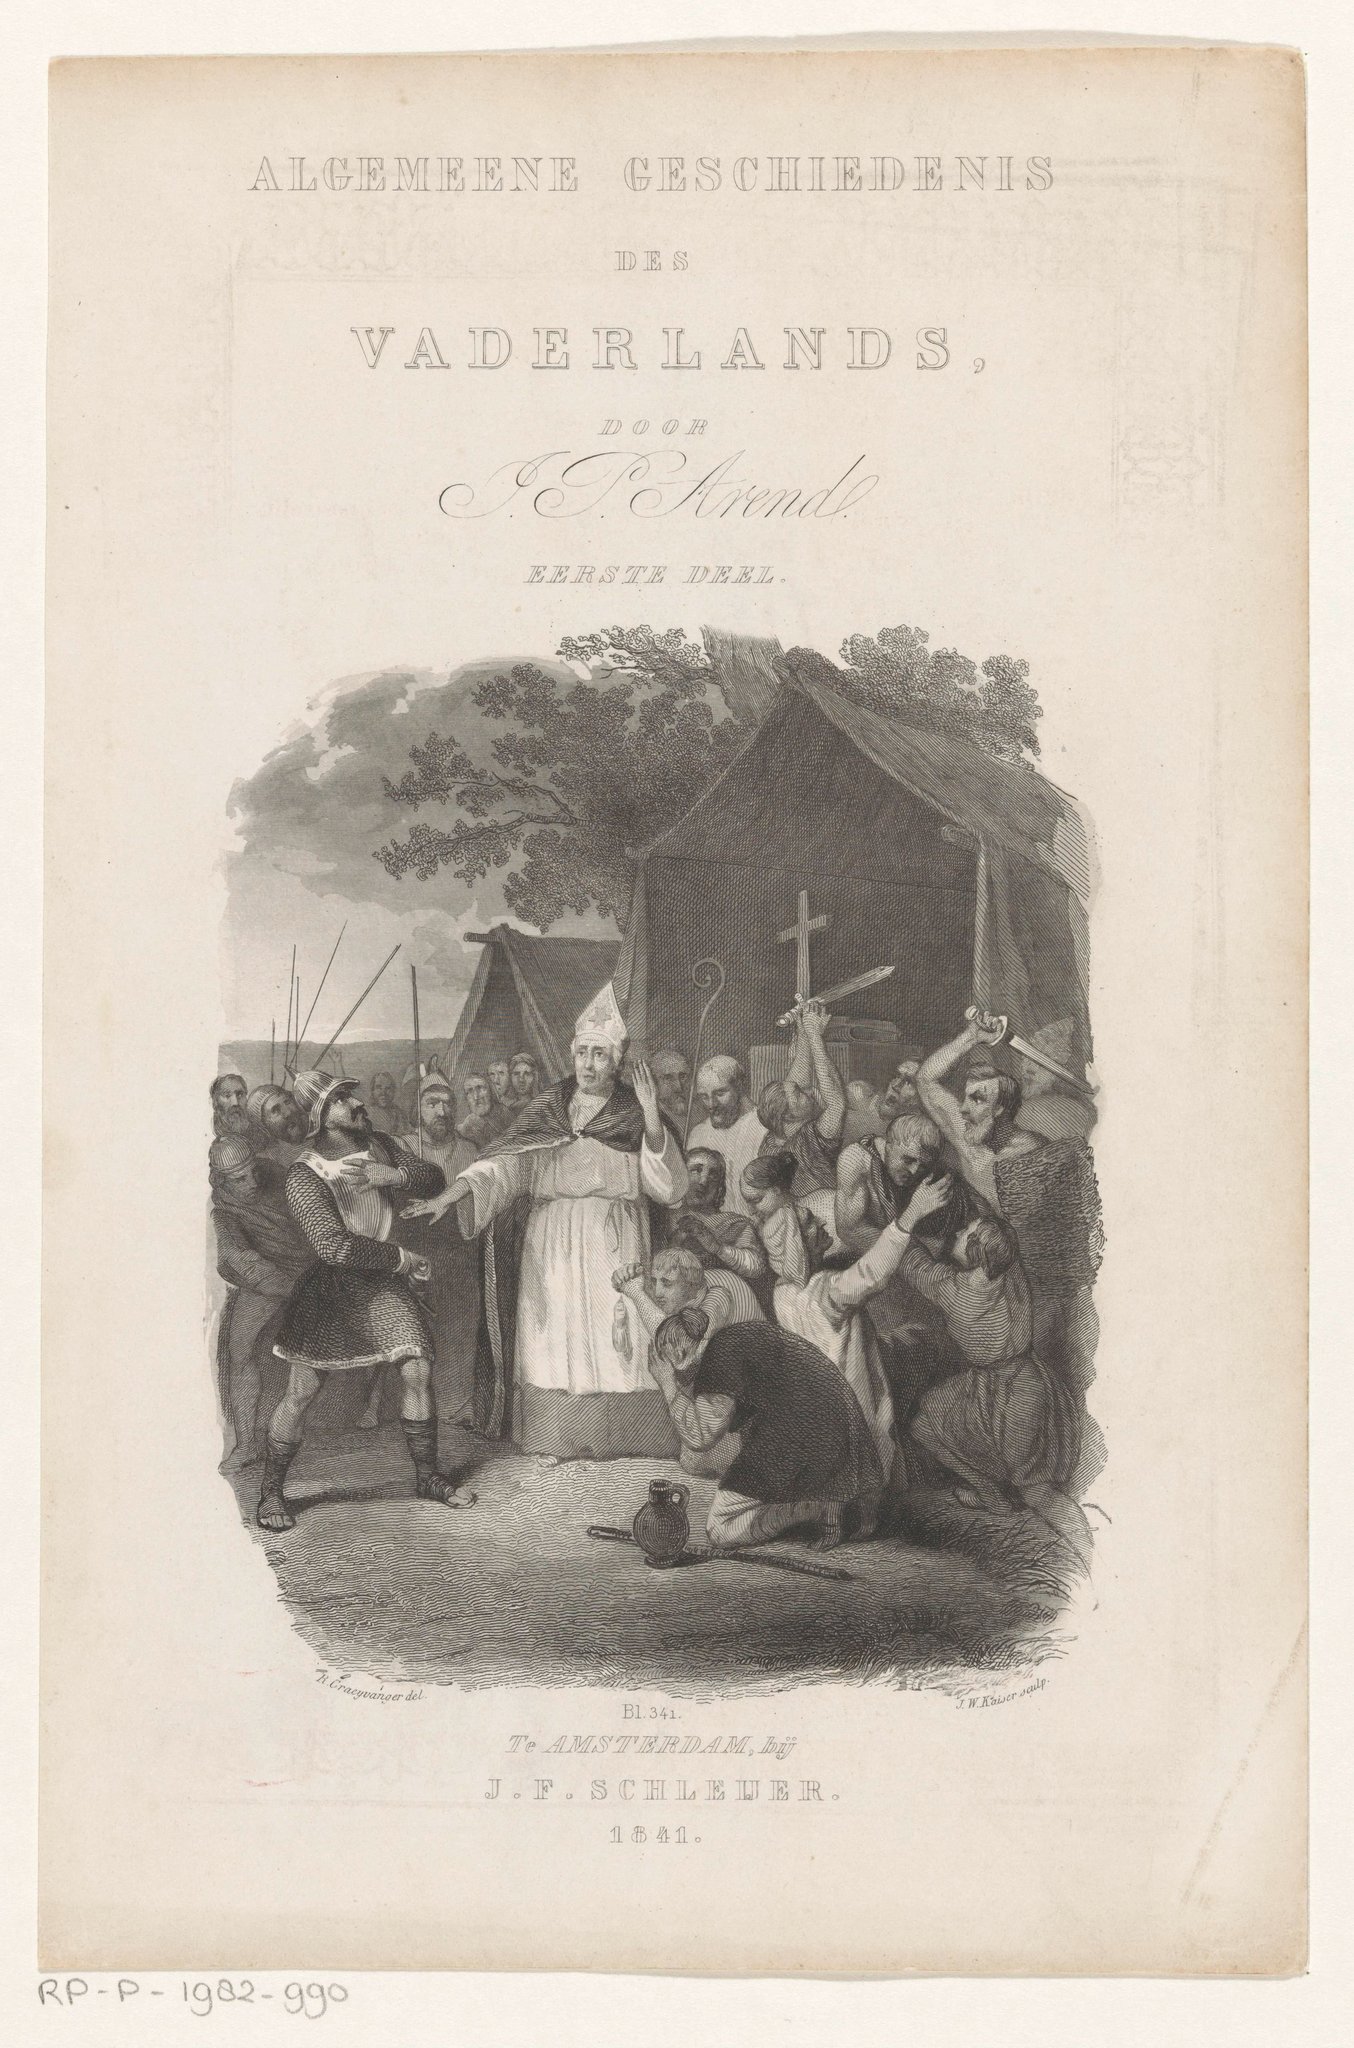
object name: print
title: Titelpagina voor: J.P. Arend, Algemeene geschiedenis des vaderlands, 1841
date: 1841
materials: paper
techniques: engraving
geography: amsterdam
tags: martyrdom, suffering, misfortune, death of st. boniface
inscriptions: collector's mark: Lugt 2760, collector's mark: Lugt 2228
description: Bonifatius trekt in 754 met een gevolg naar Friesland, om de Friezen te bekeren tot het christendom. Te Dokkum slaat hij een kamp op en belegt een grote bijeenkomt om de nieuw bekeerden gemeenschappelijk het sacrament van het heilig vormsel toe te dienen. Bonifatius en zijn gevolg worden overvallen door een groep gewapende Friezen. Bonifatius gebiedt zijn volgelingen hun wapens niet te gebruiken om een bloedbad te voorkomen.